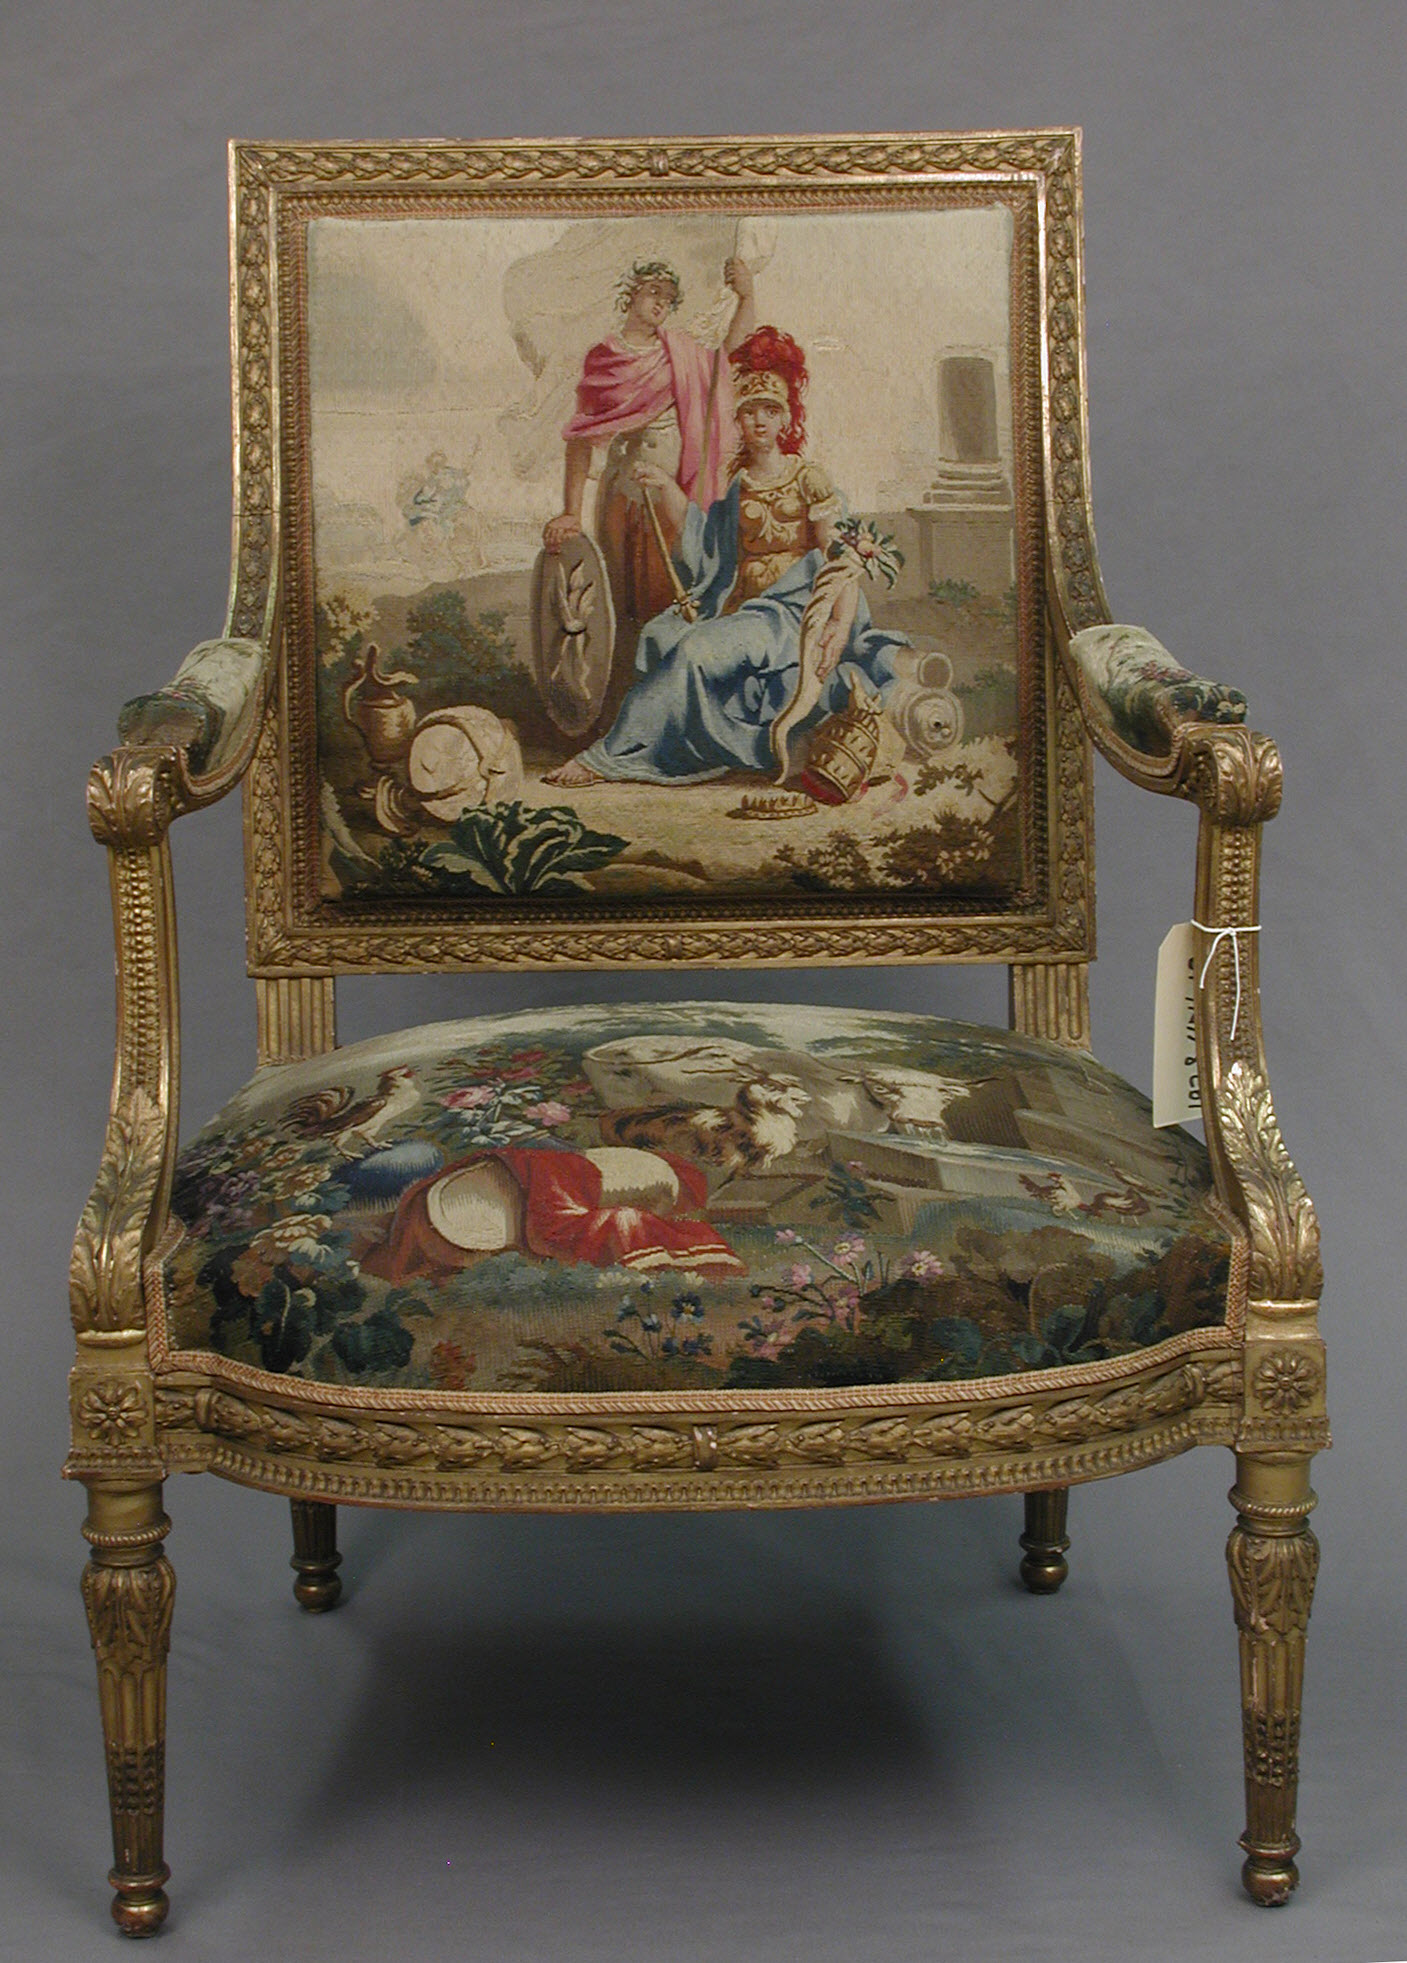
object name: armchair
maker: beauvais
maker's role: manufactory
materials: silk, wood, wool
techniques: carving, gilding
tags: chickens,women,goats,ox